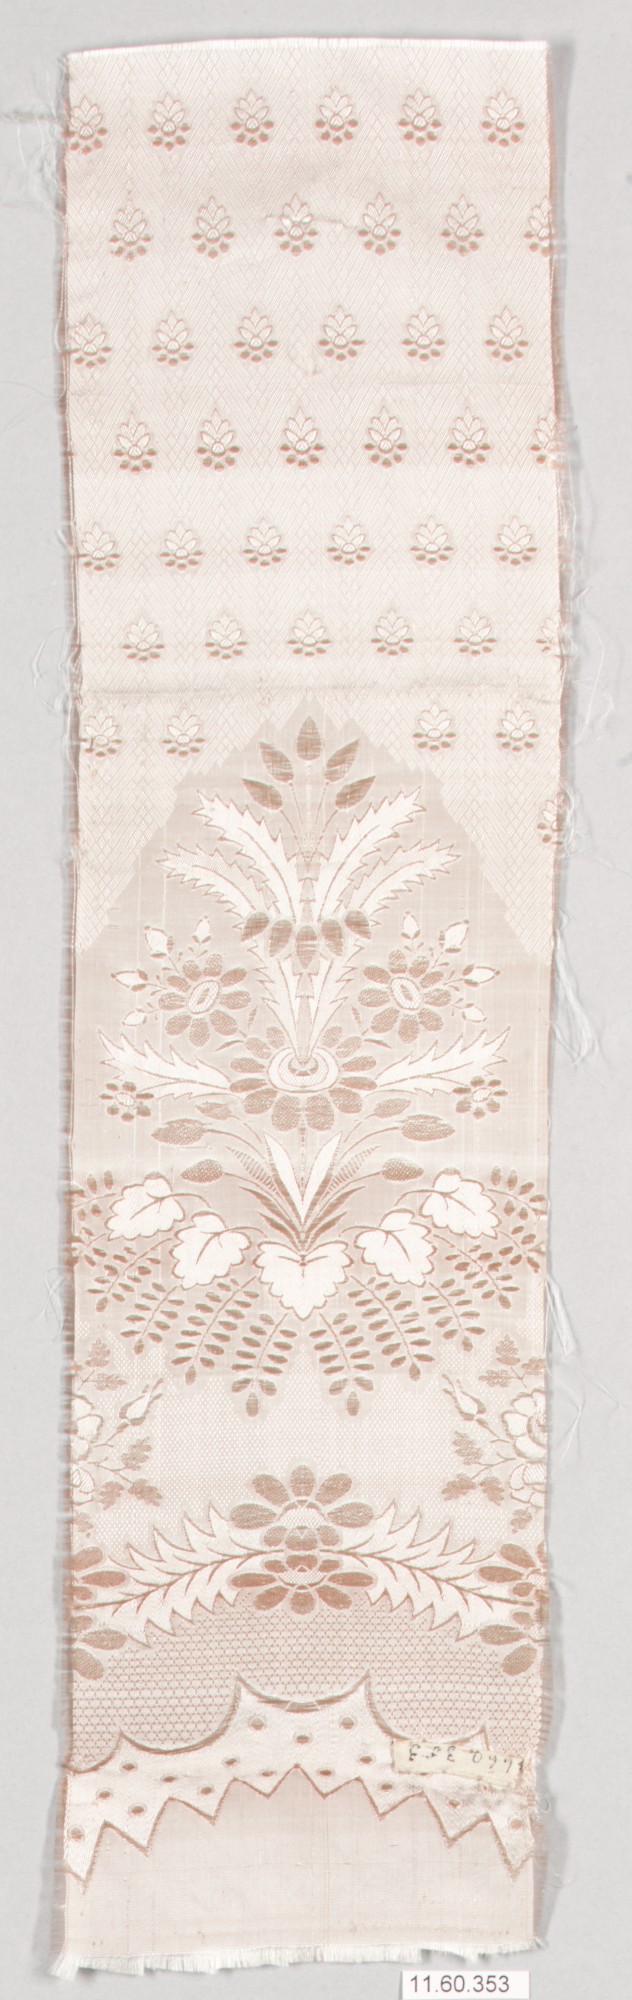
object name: fragment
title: Fragments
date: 1801-1900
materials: silk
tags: flowers,leaves